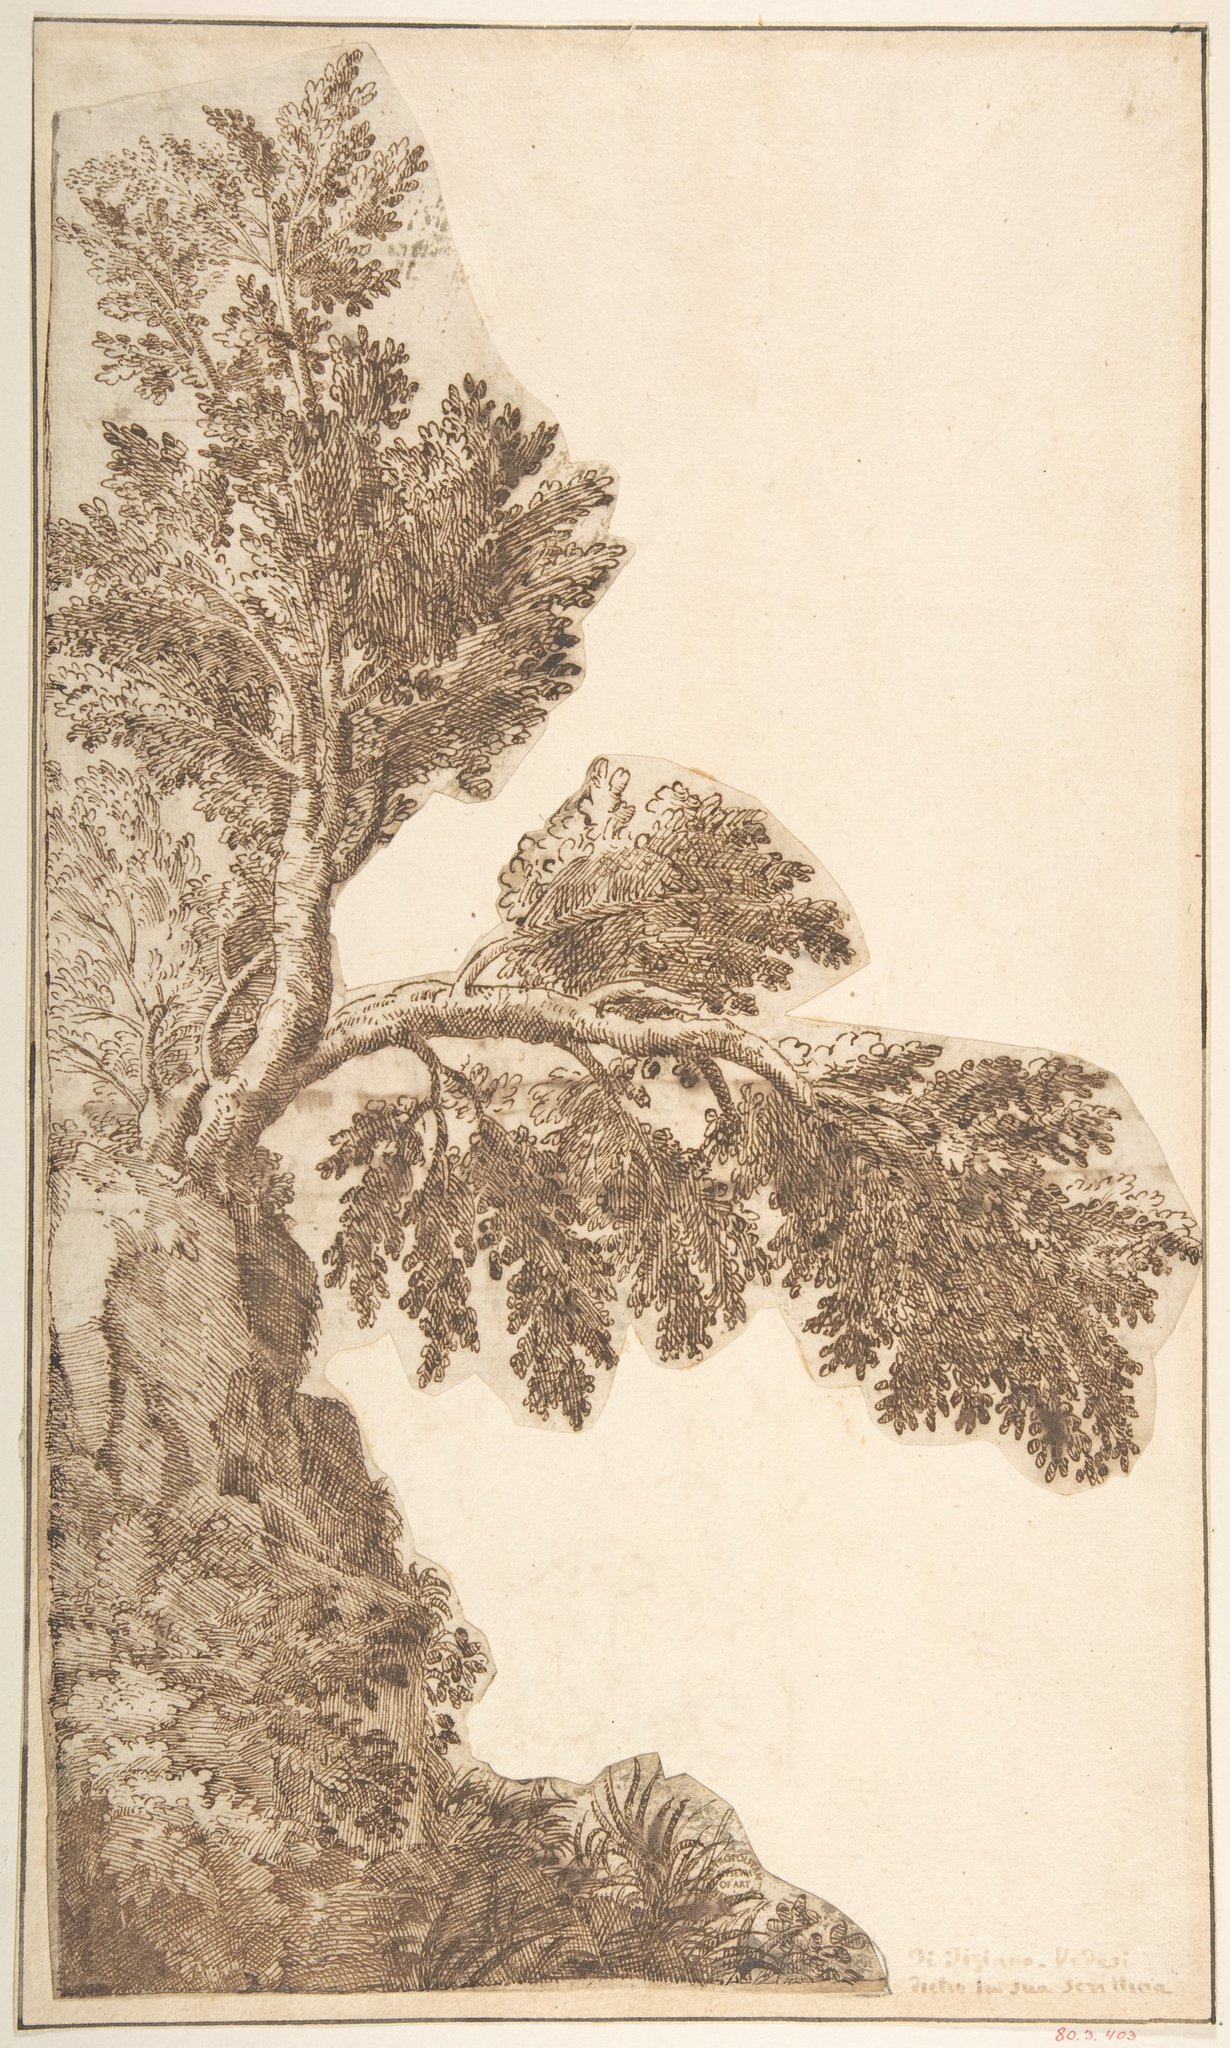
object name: drawing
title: Trees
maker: anonymous, italian, venetian, 15th to 16th century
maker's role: artist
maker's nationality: italian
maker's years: 1400-1600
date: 1501-1600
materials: ink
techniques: pen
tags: trees